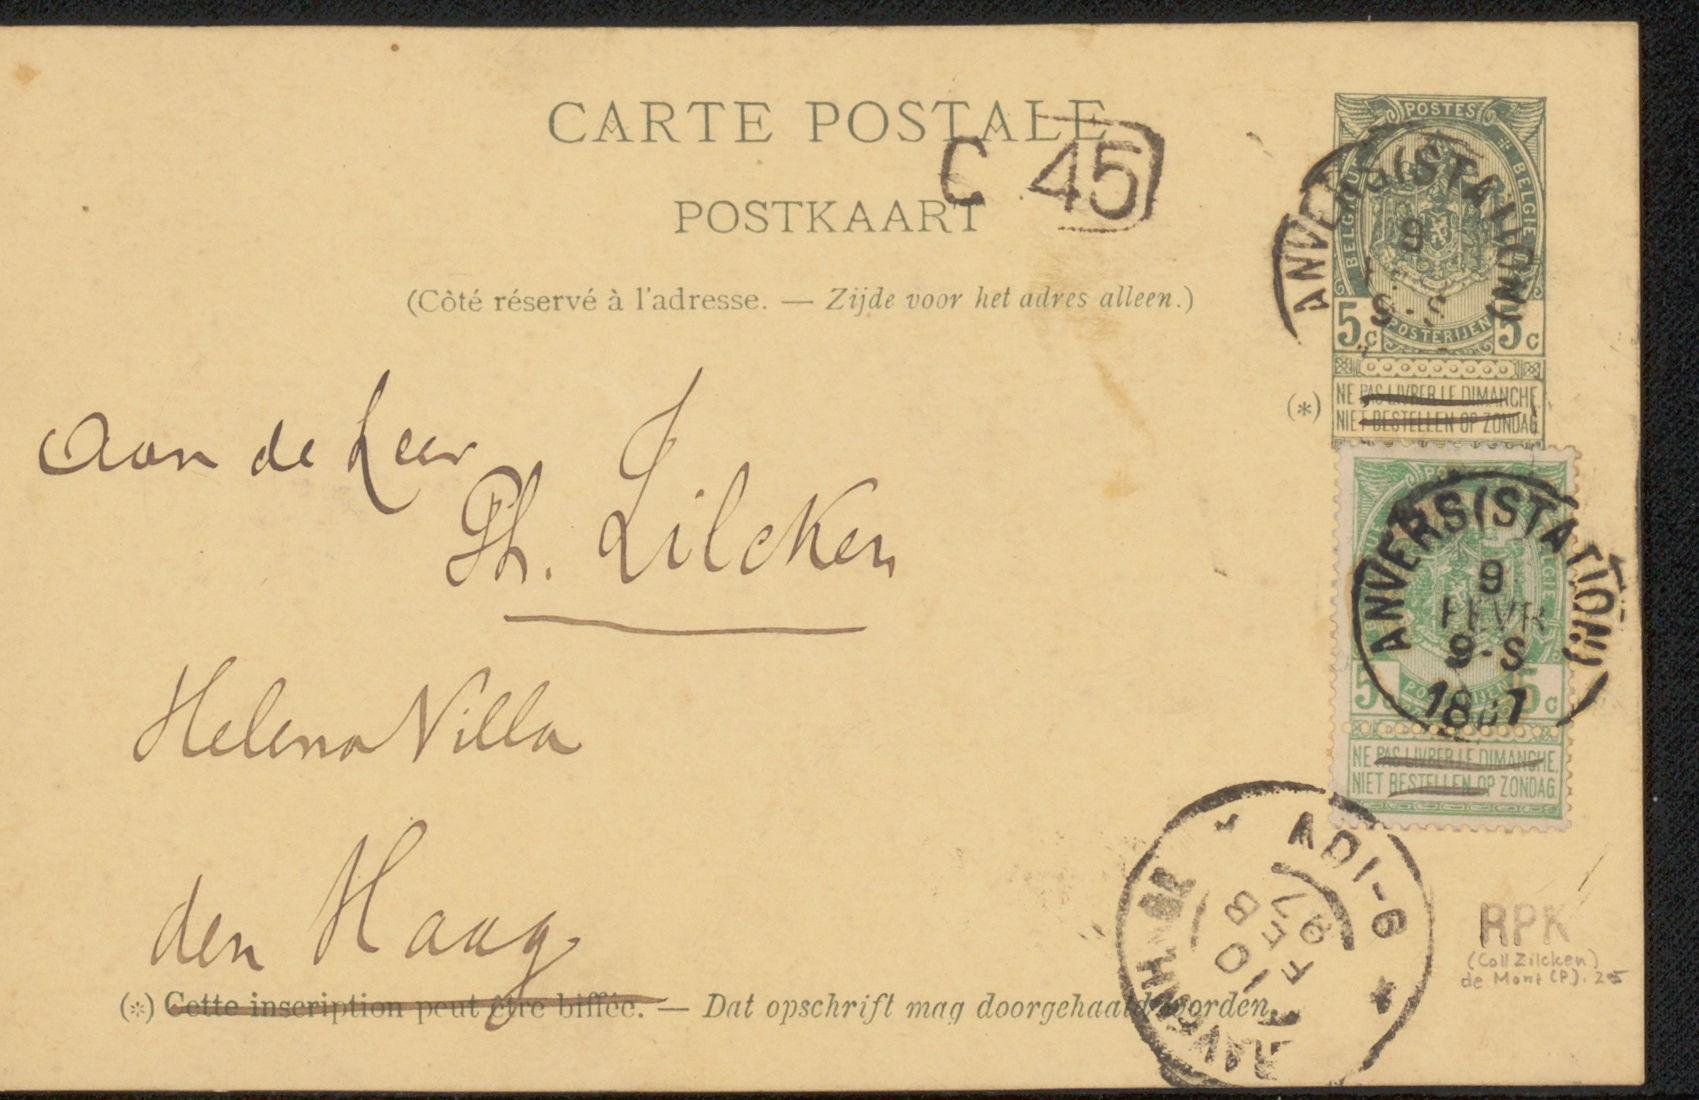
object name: postcard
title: Briefkaart aan Philip Zilcken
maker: pol de mont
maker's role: dichter, prozaschrijver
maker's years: 1857-1931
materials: cardboard, ink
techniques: pen, writing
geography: antwerp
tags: lierre, print maker, jan van beers (schilder), the hague, draughtsman, philip zilcken, photography, cinematography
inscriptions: collector's mark: ‘RPK’